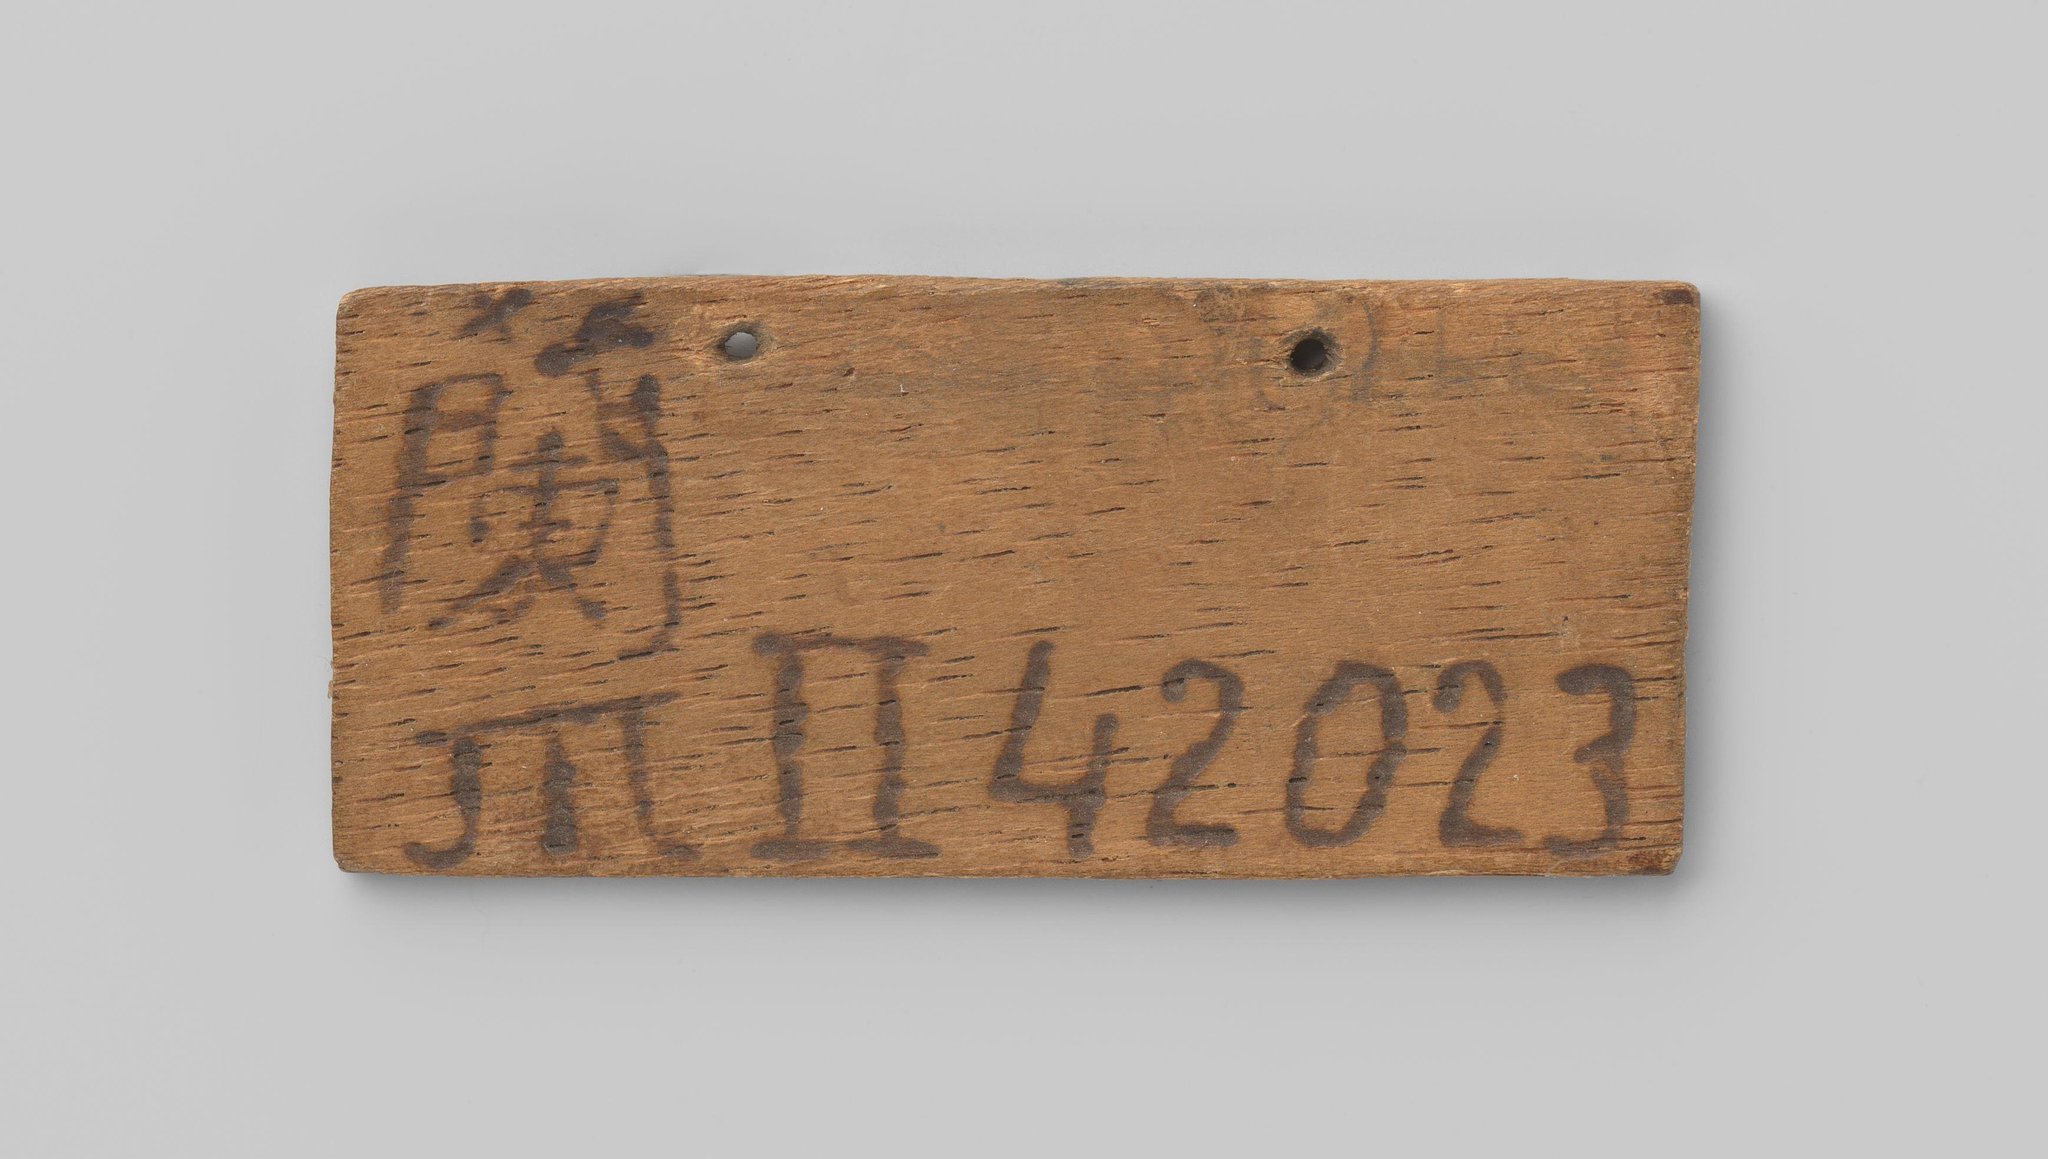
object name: object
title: P.O.W.-nummer 42023 van Wim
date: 1944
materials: wood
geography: batavia